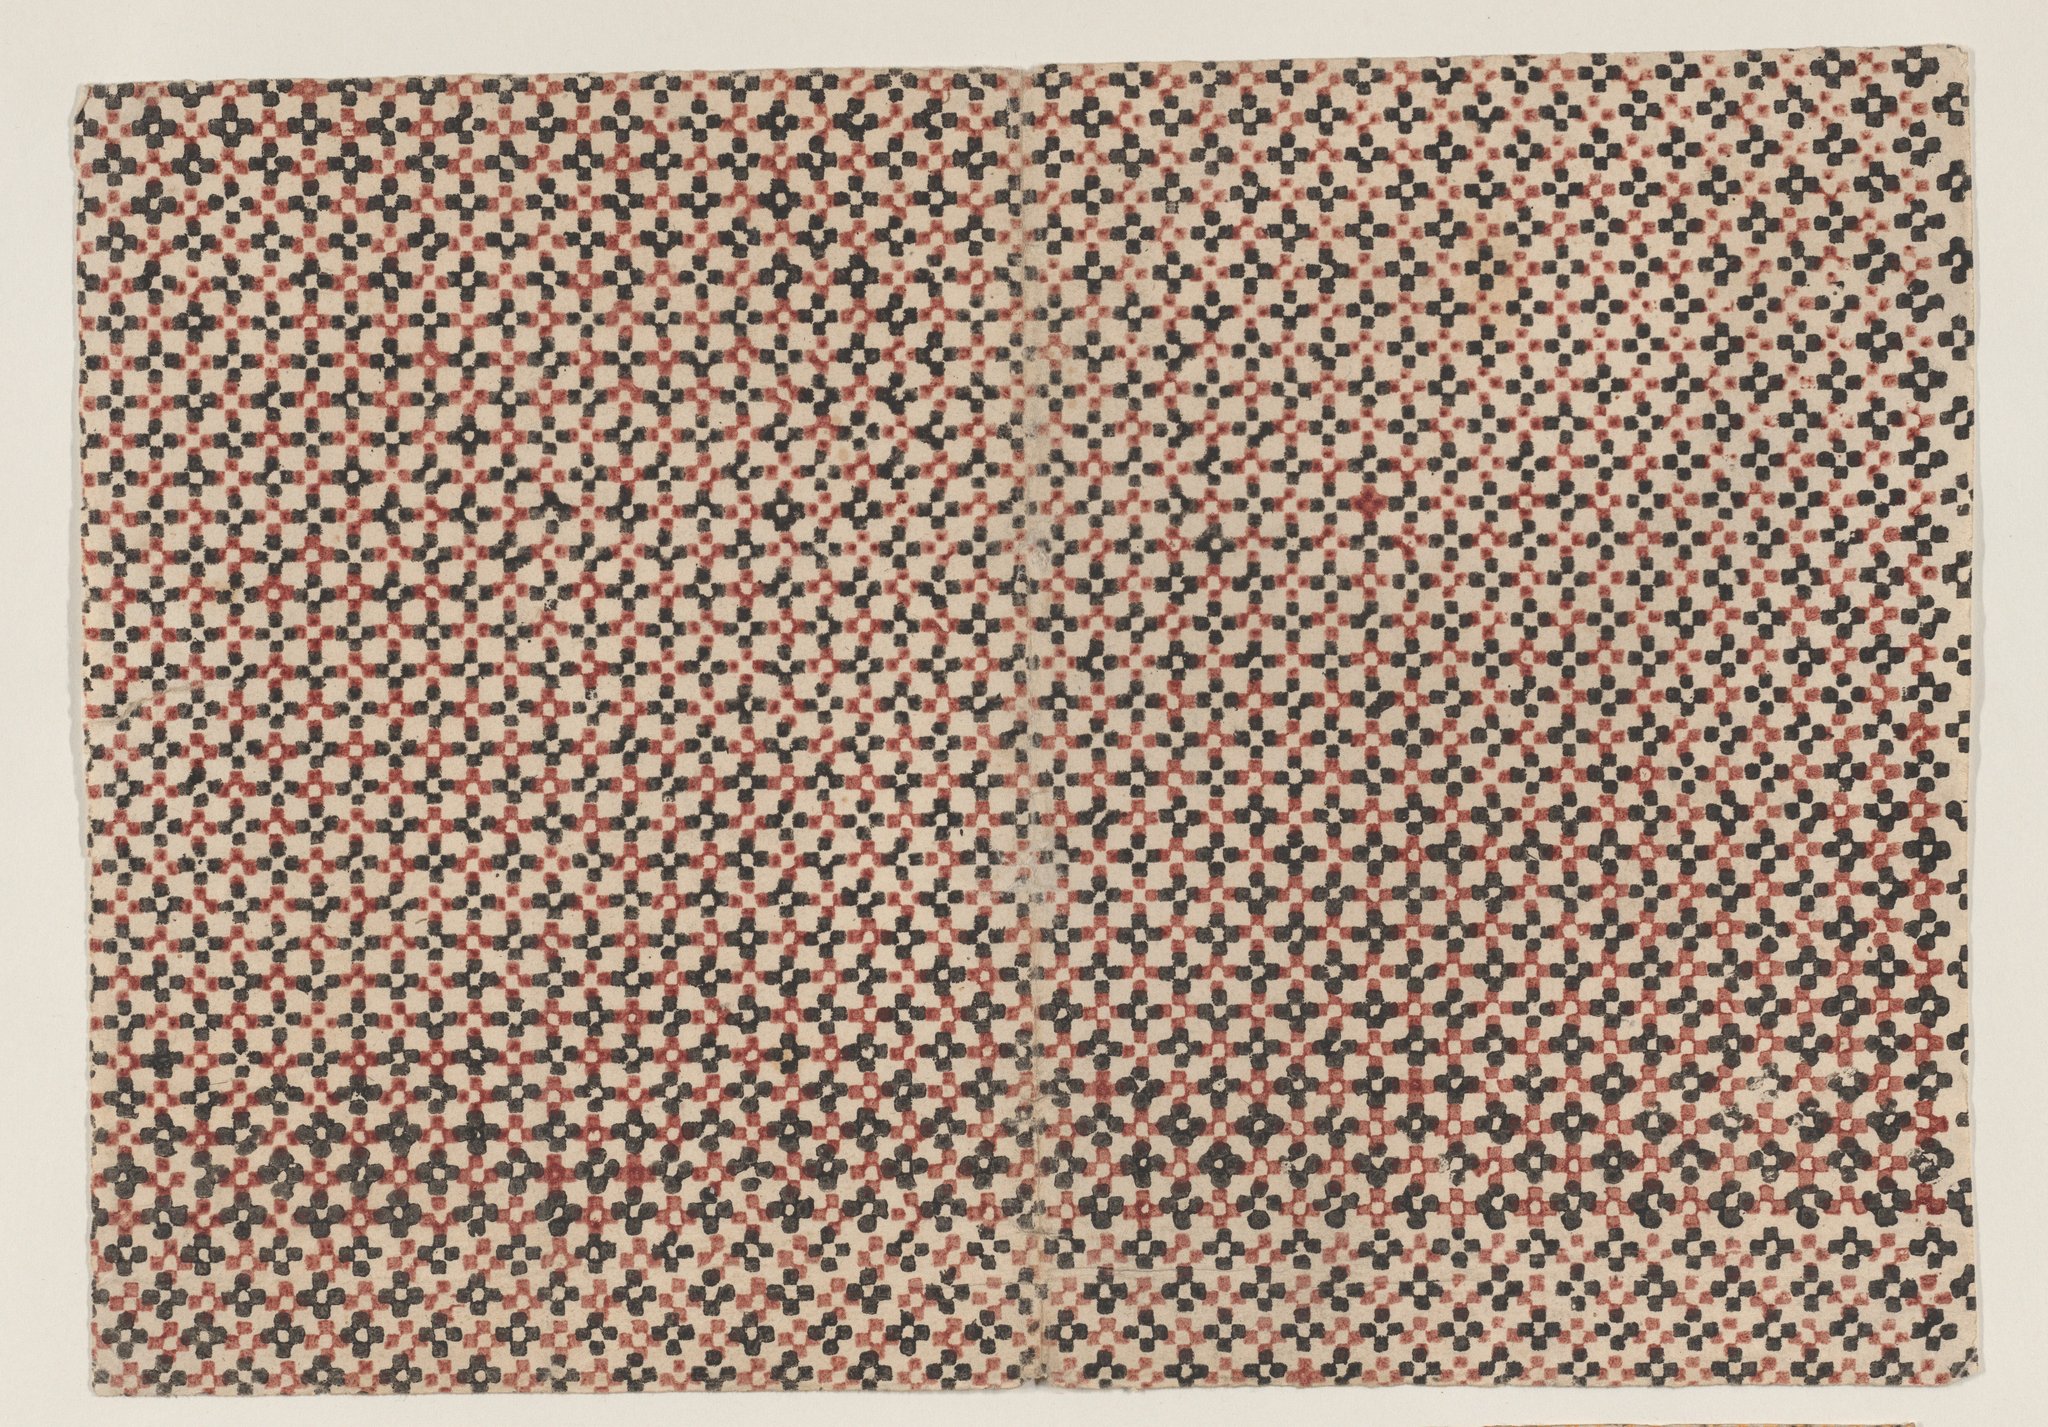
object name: print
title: Sheet with overall geometric pattern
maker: Anonymous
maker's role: artist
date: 1801-1900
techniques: relief print